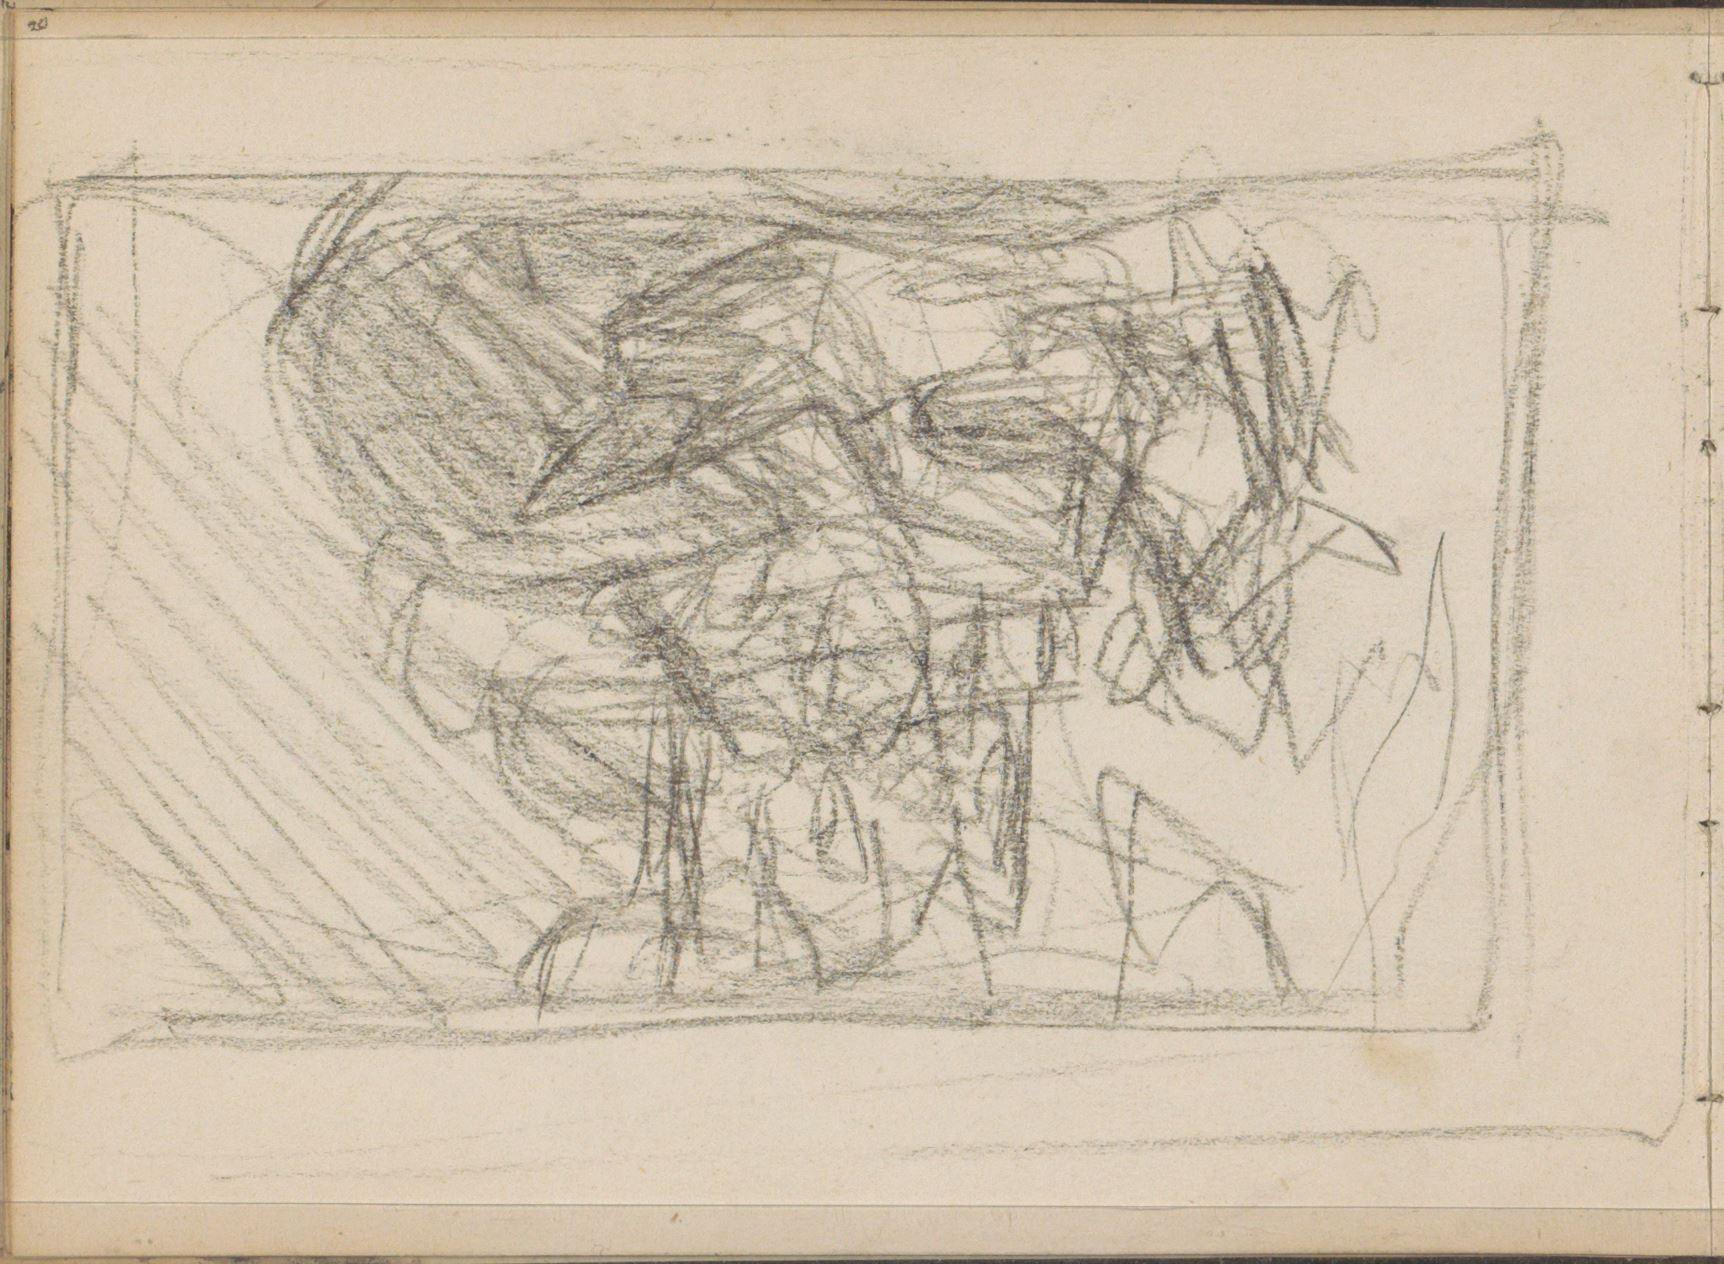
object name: sketchbook leaf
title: Studie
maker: marius bauer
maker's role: draughtsman, print maker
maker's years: 1867-1932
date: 1877-1932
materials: chalk, paper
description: Pagina 20 uit een schetsboek met 32 bladen.